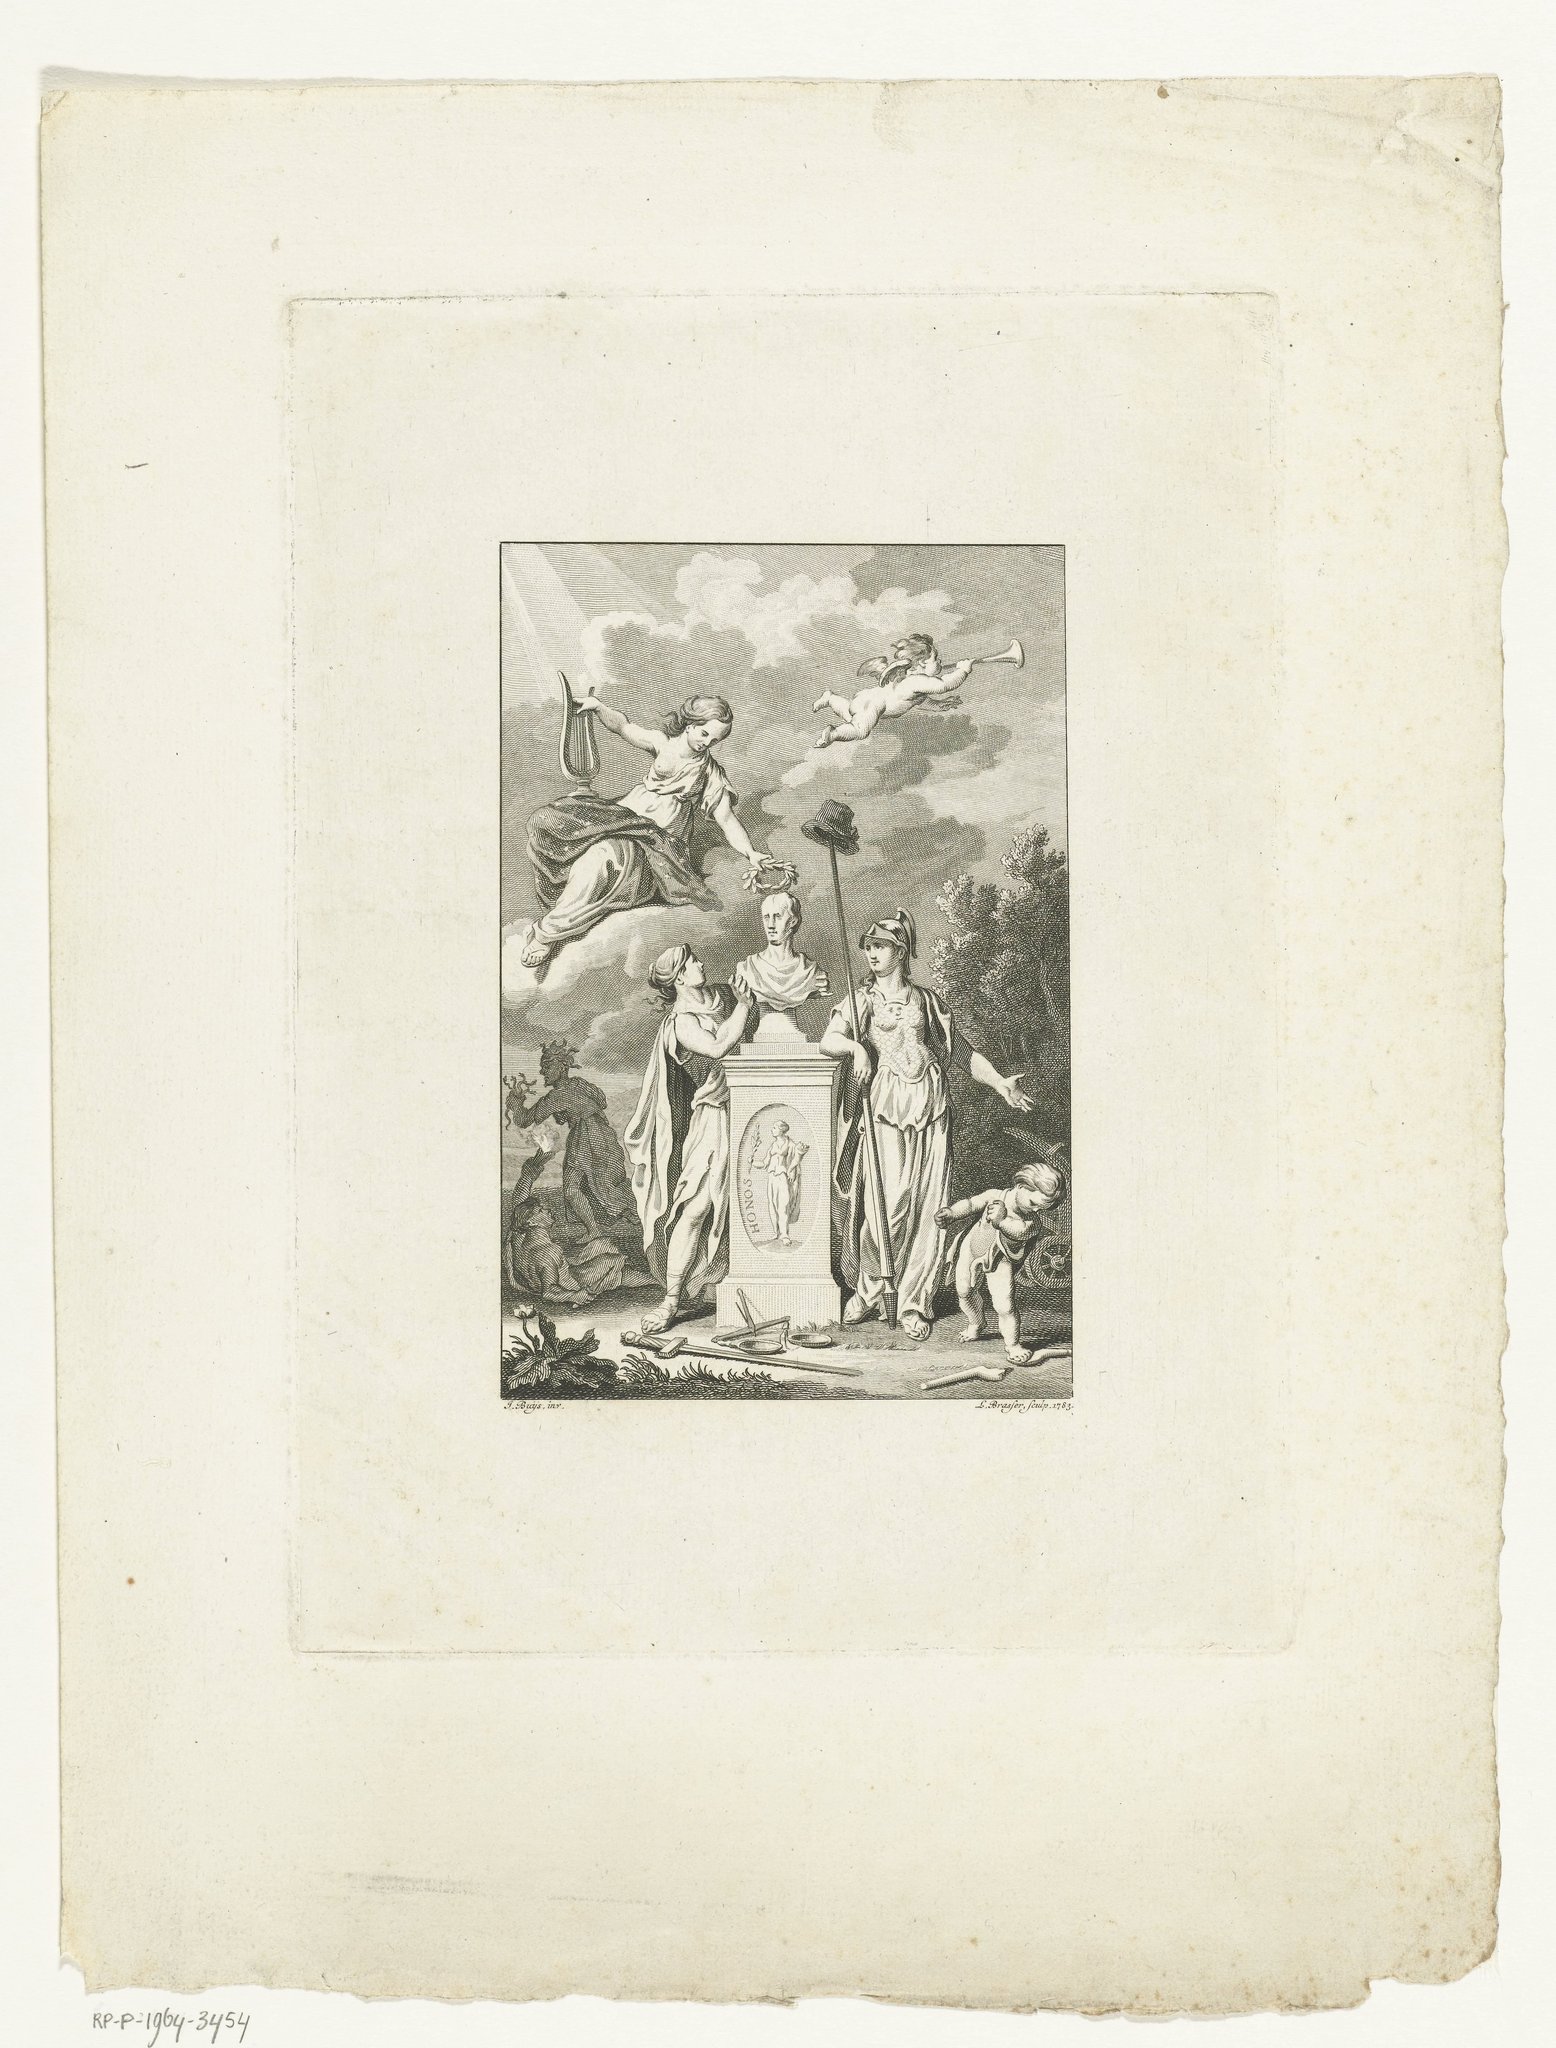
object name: print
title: Buste van dichter gelauwerd door drie muzen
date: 1783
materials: paper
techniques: engraving, etching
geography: rotterdam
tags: bard, lyric poet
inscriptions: collector's mark: Lugt 2228